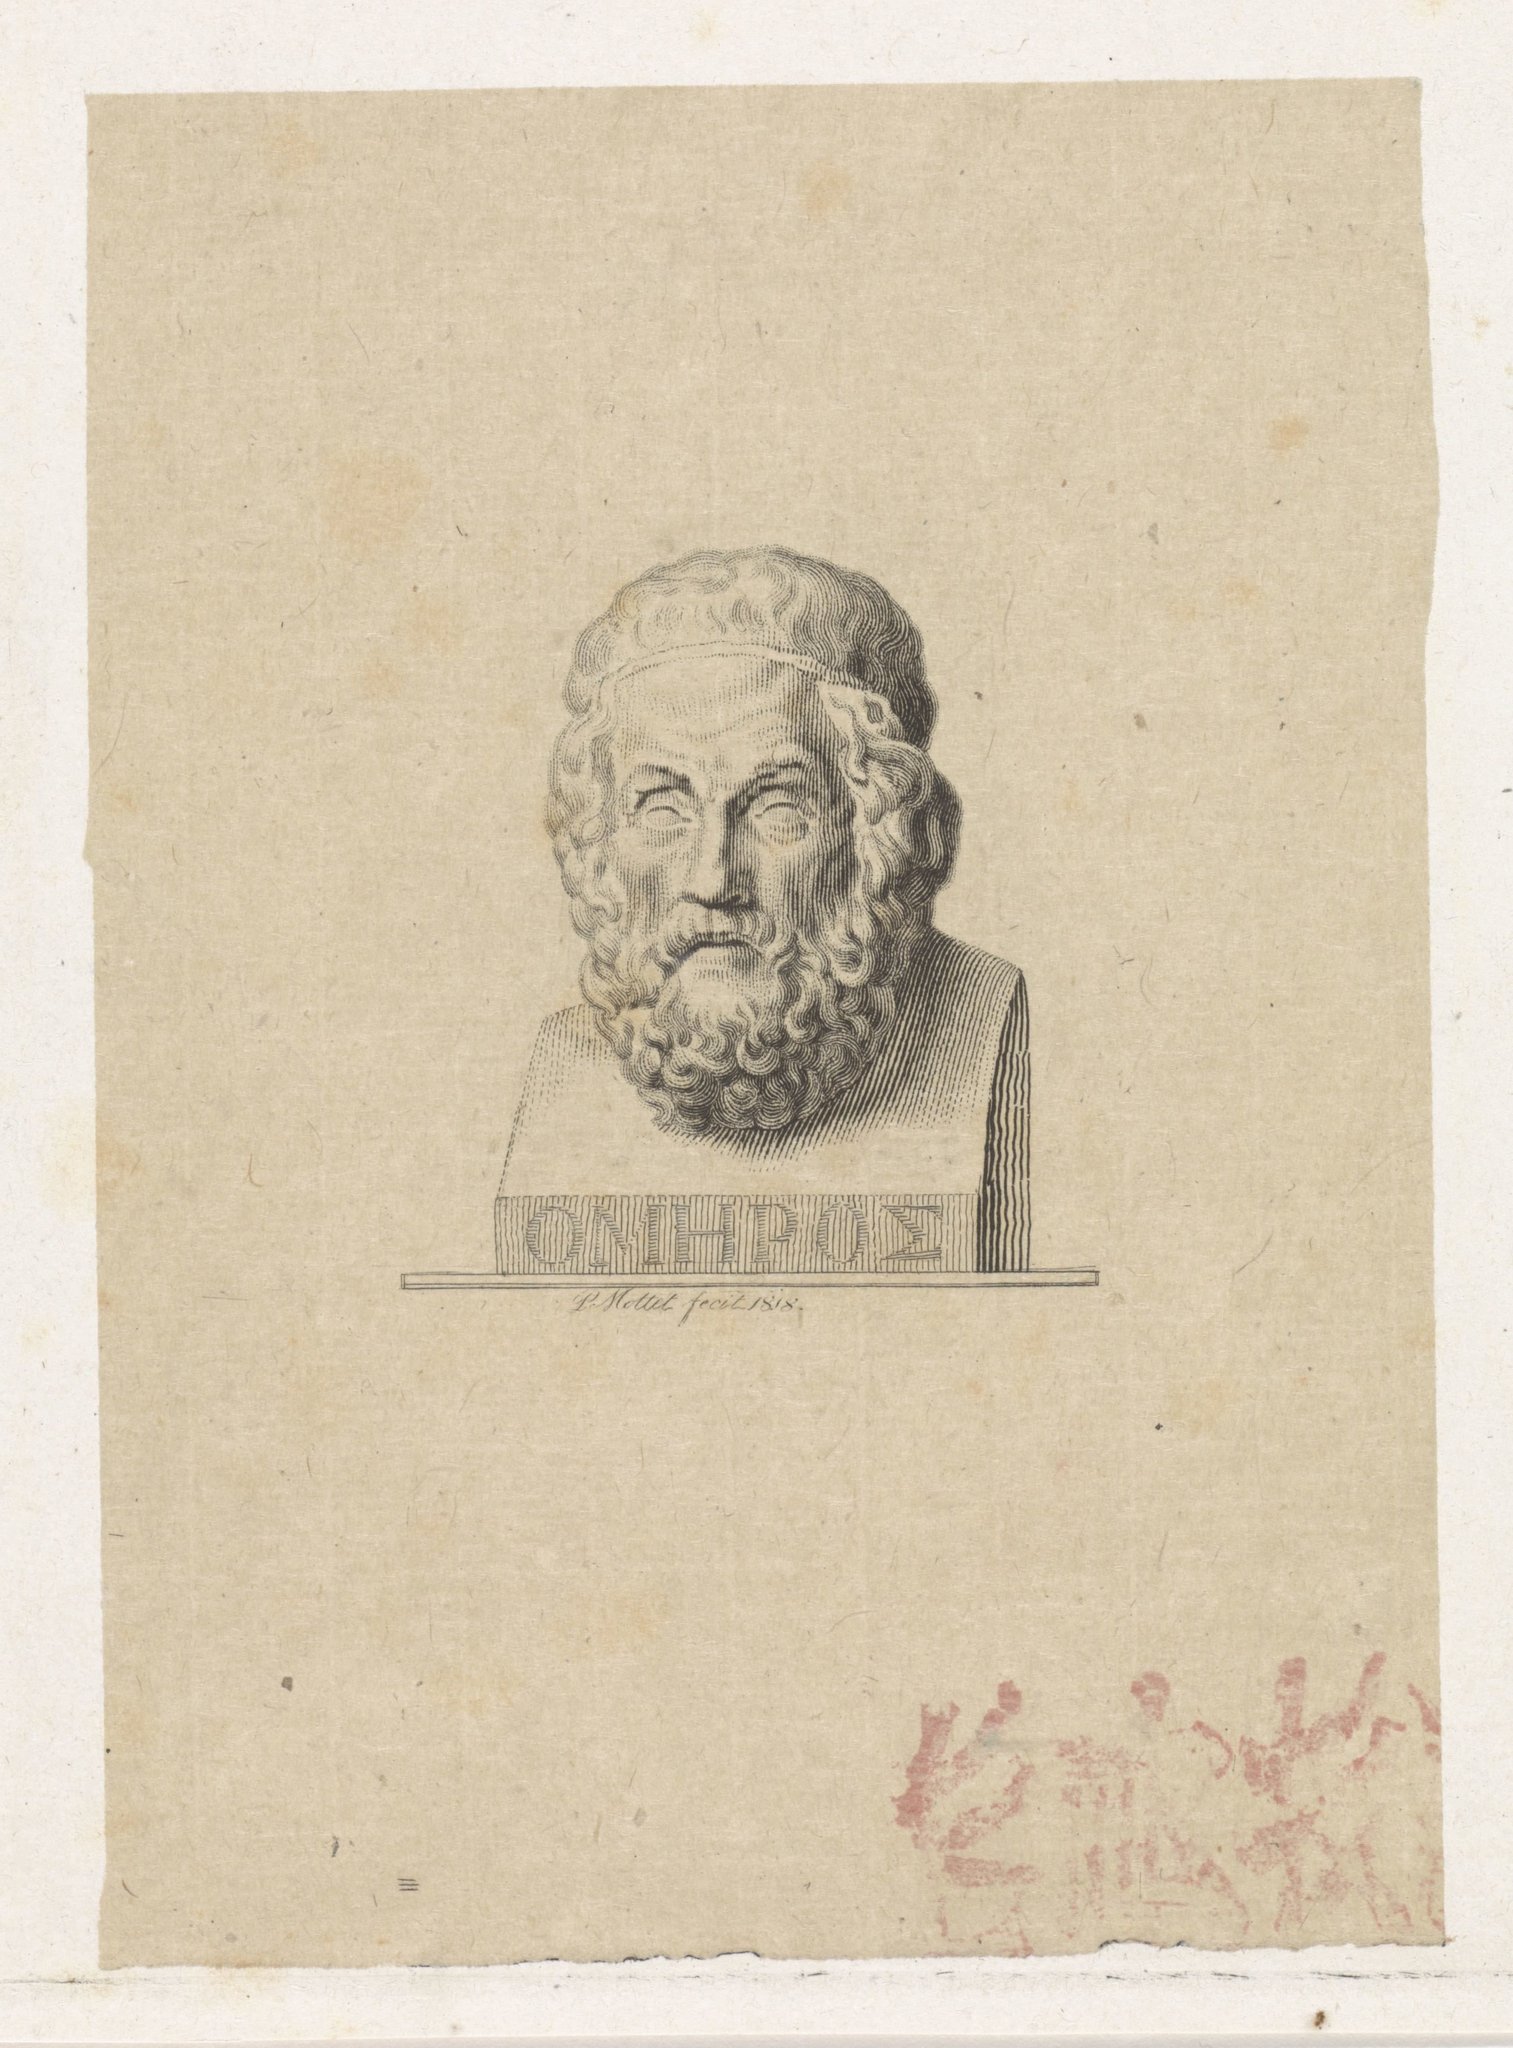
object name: print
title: Borstbeeld van de Griekse dichter Homerus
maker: p. mottet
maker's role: print maker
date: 1818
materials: paper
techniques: etching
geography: amsterdam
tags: homerus, piece of sculpture, reproduction of a piece of sculpture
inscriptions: collector's mark: Lugt 2228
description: Borstbeeld van de Griekse dichter Homerus. Op de onderste rand zijn naam in het Grieks.